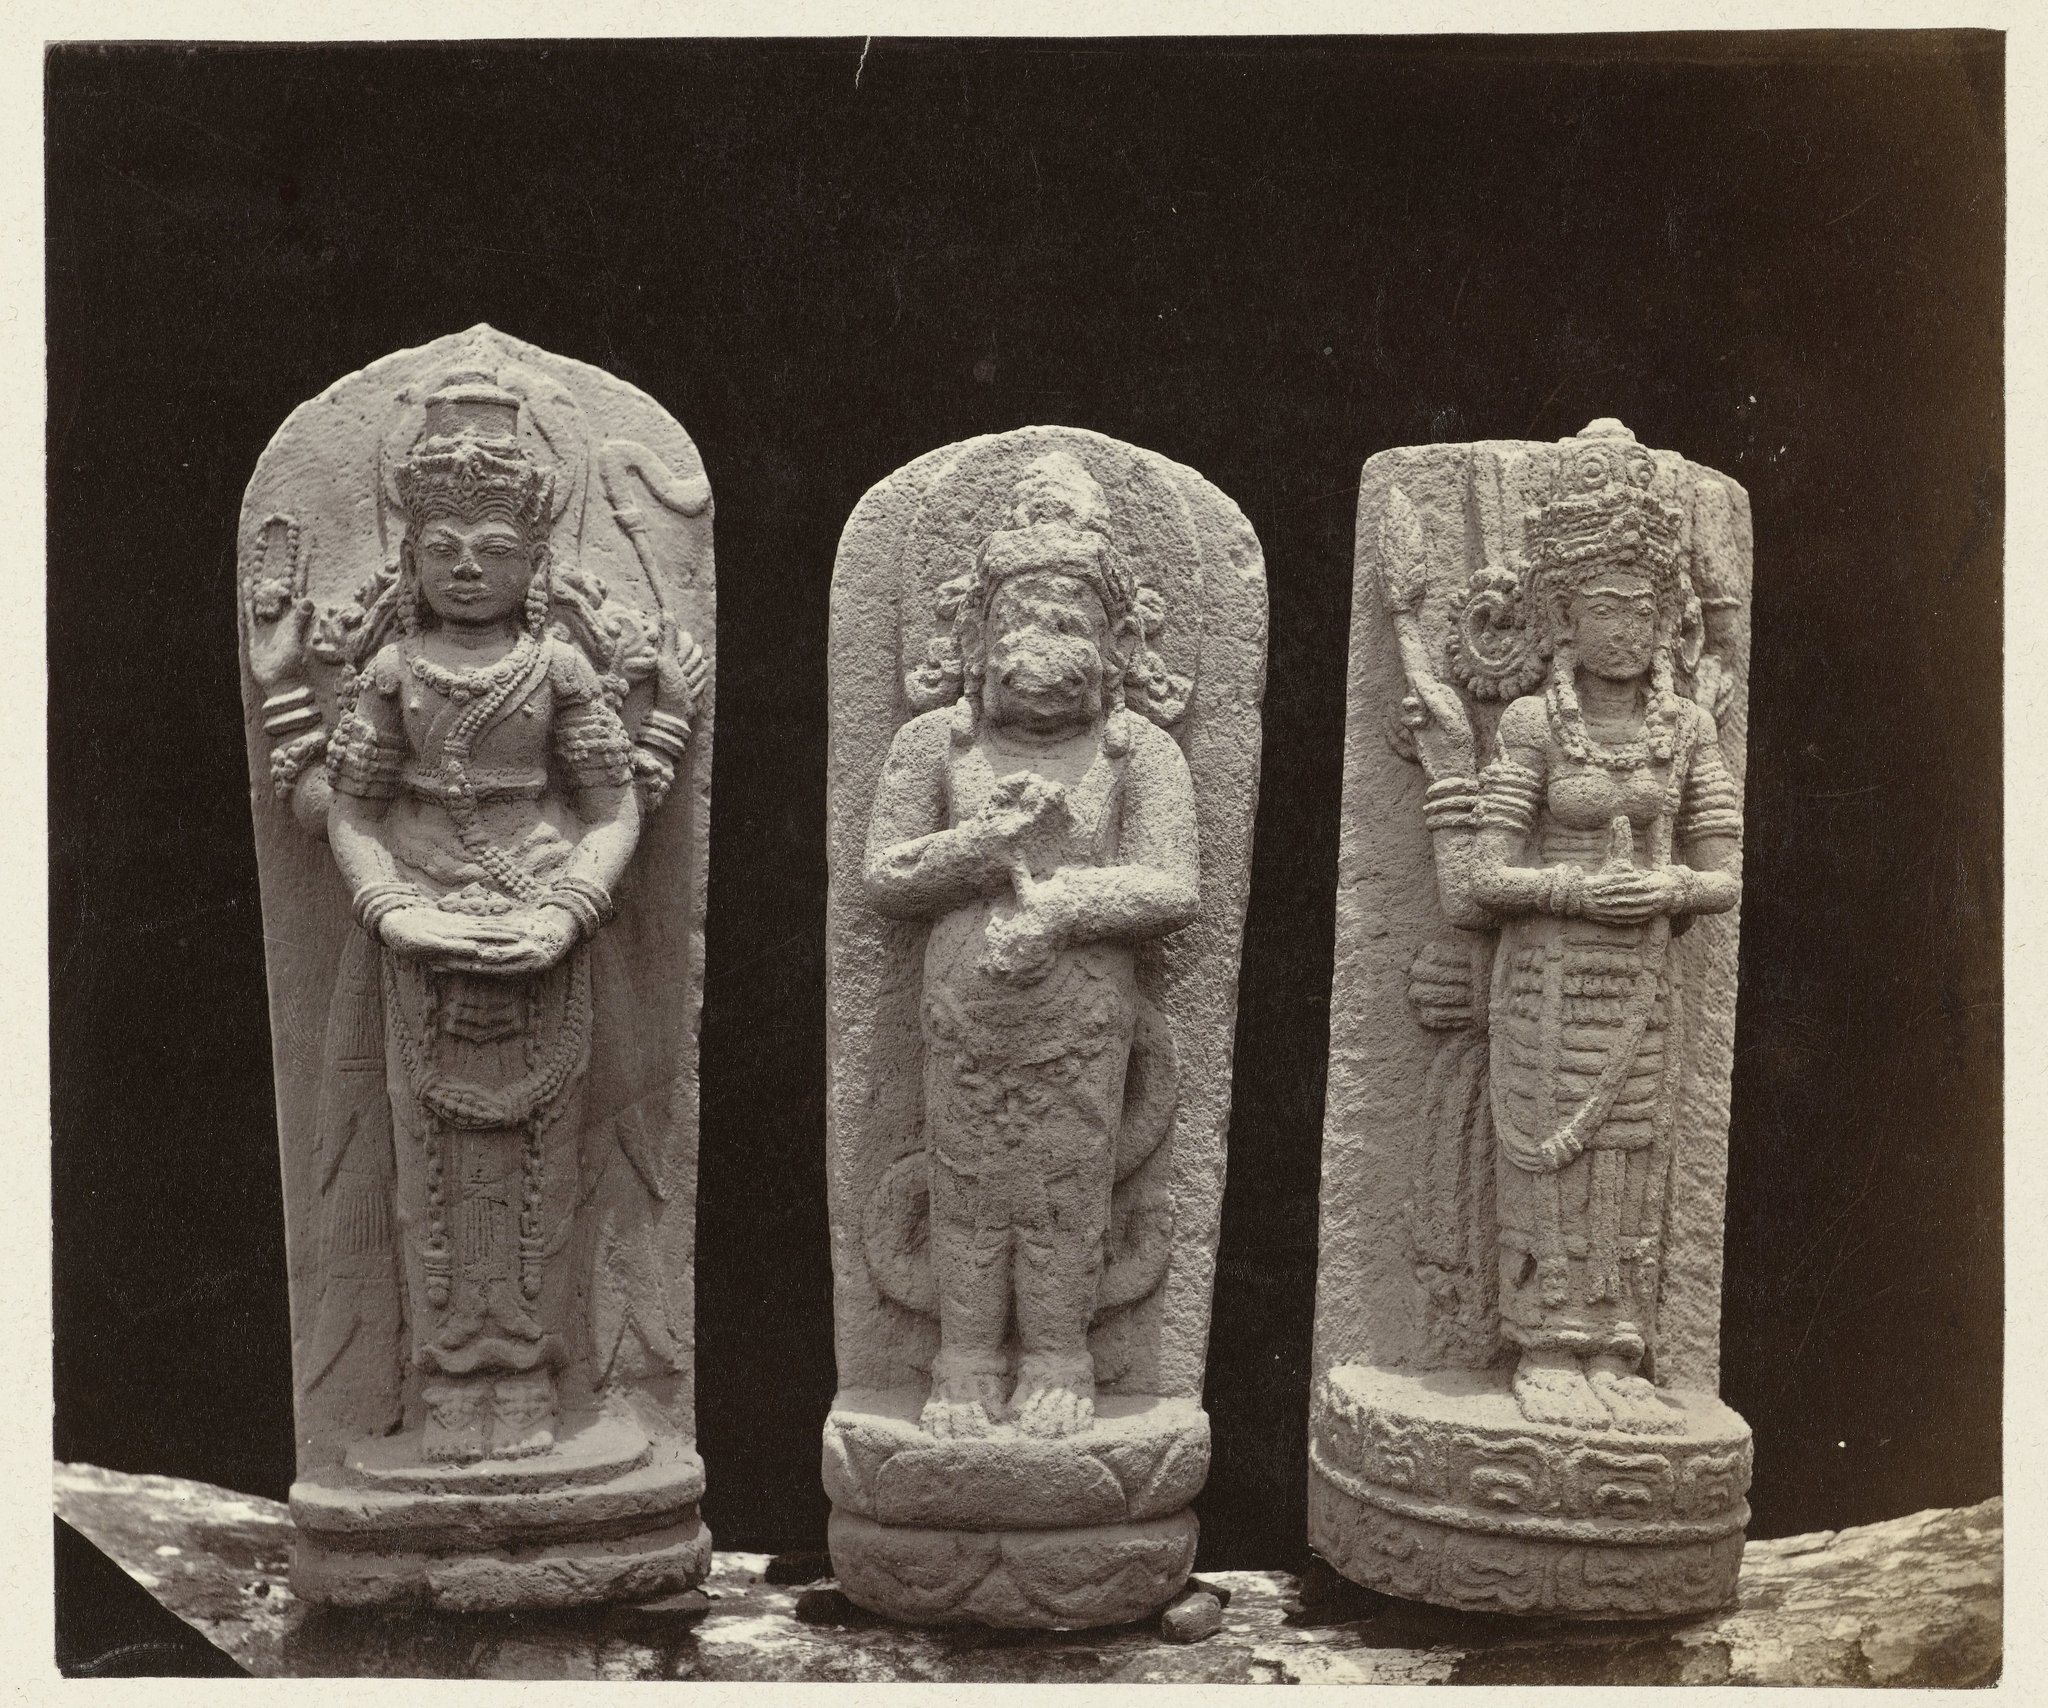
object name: photograph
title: Three steles; Hanuman (middle) and two deification images, the left showing features of Parvati, the right of Lakshmi (Residential house) Kediri, Kediri district, East Java province, various periods.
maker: isidore kinsbergen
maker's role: fotograaf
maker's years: 1821-1905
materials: cardboard, paper, photographic support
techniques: albumen print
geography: java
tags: parvati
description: De beelden waren geplaats bij het residentie huis in Kediri.